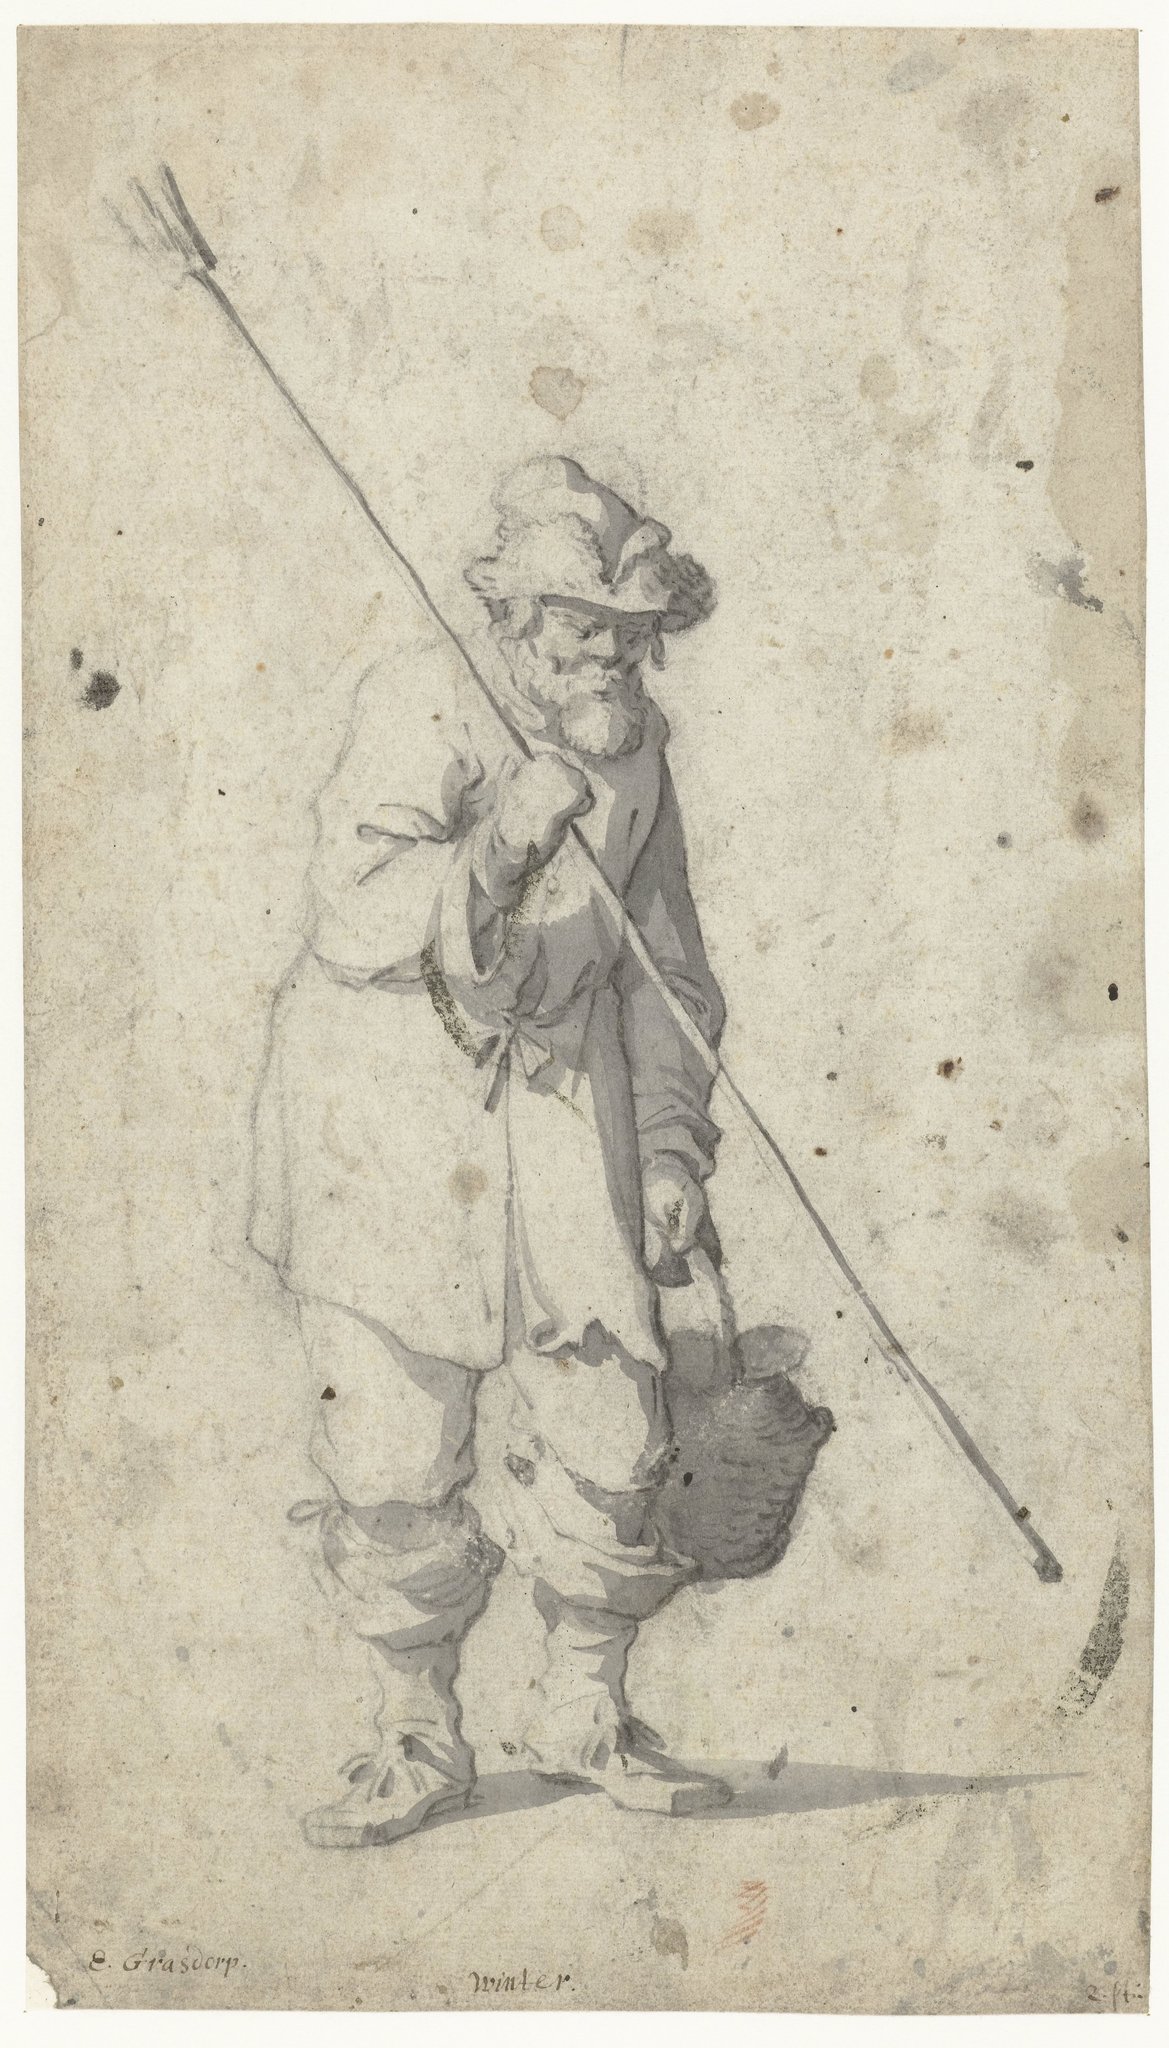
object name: drawing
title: Winter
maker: gerrit grasdorp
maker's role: draughtsman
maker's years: 1659-1716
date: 1661-1693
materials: chalk, paper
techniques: brush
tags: winter, 'hyems'; 'inverno' (ripa), fisherman (+ trident)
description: Een oude staande visser met een bontmuts en een drietand.